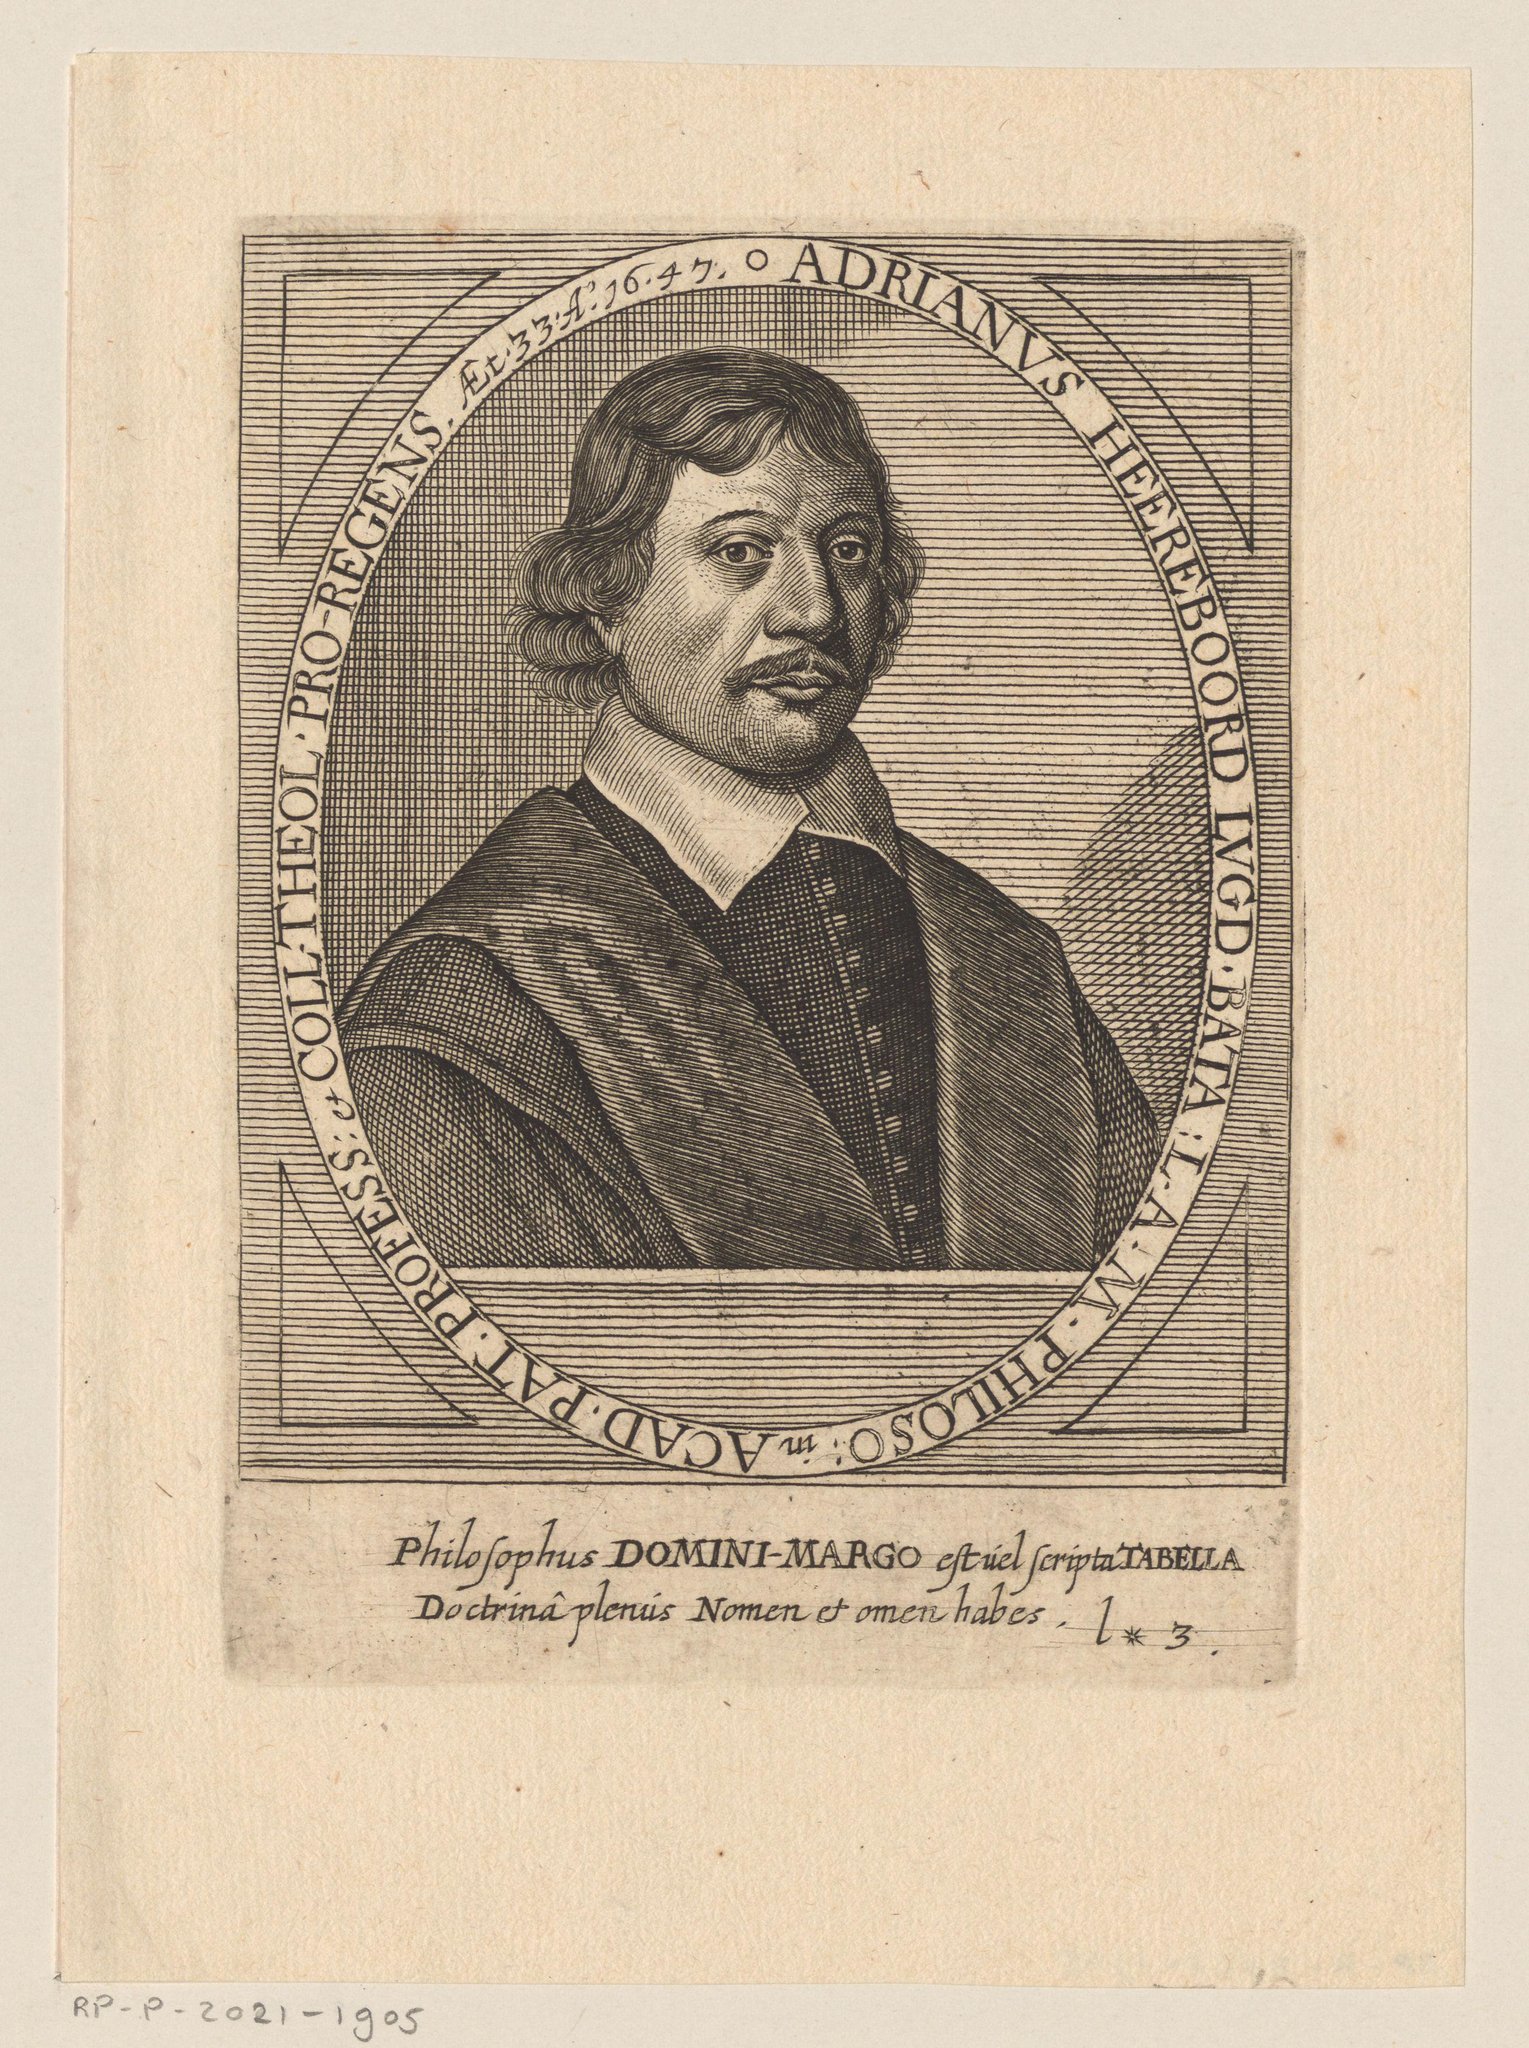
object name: print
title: Portretten van geleerden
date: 1654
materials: paper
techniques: engraving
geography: heidelberg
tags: leiden, scholar, philosopher, historical persons